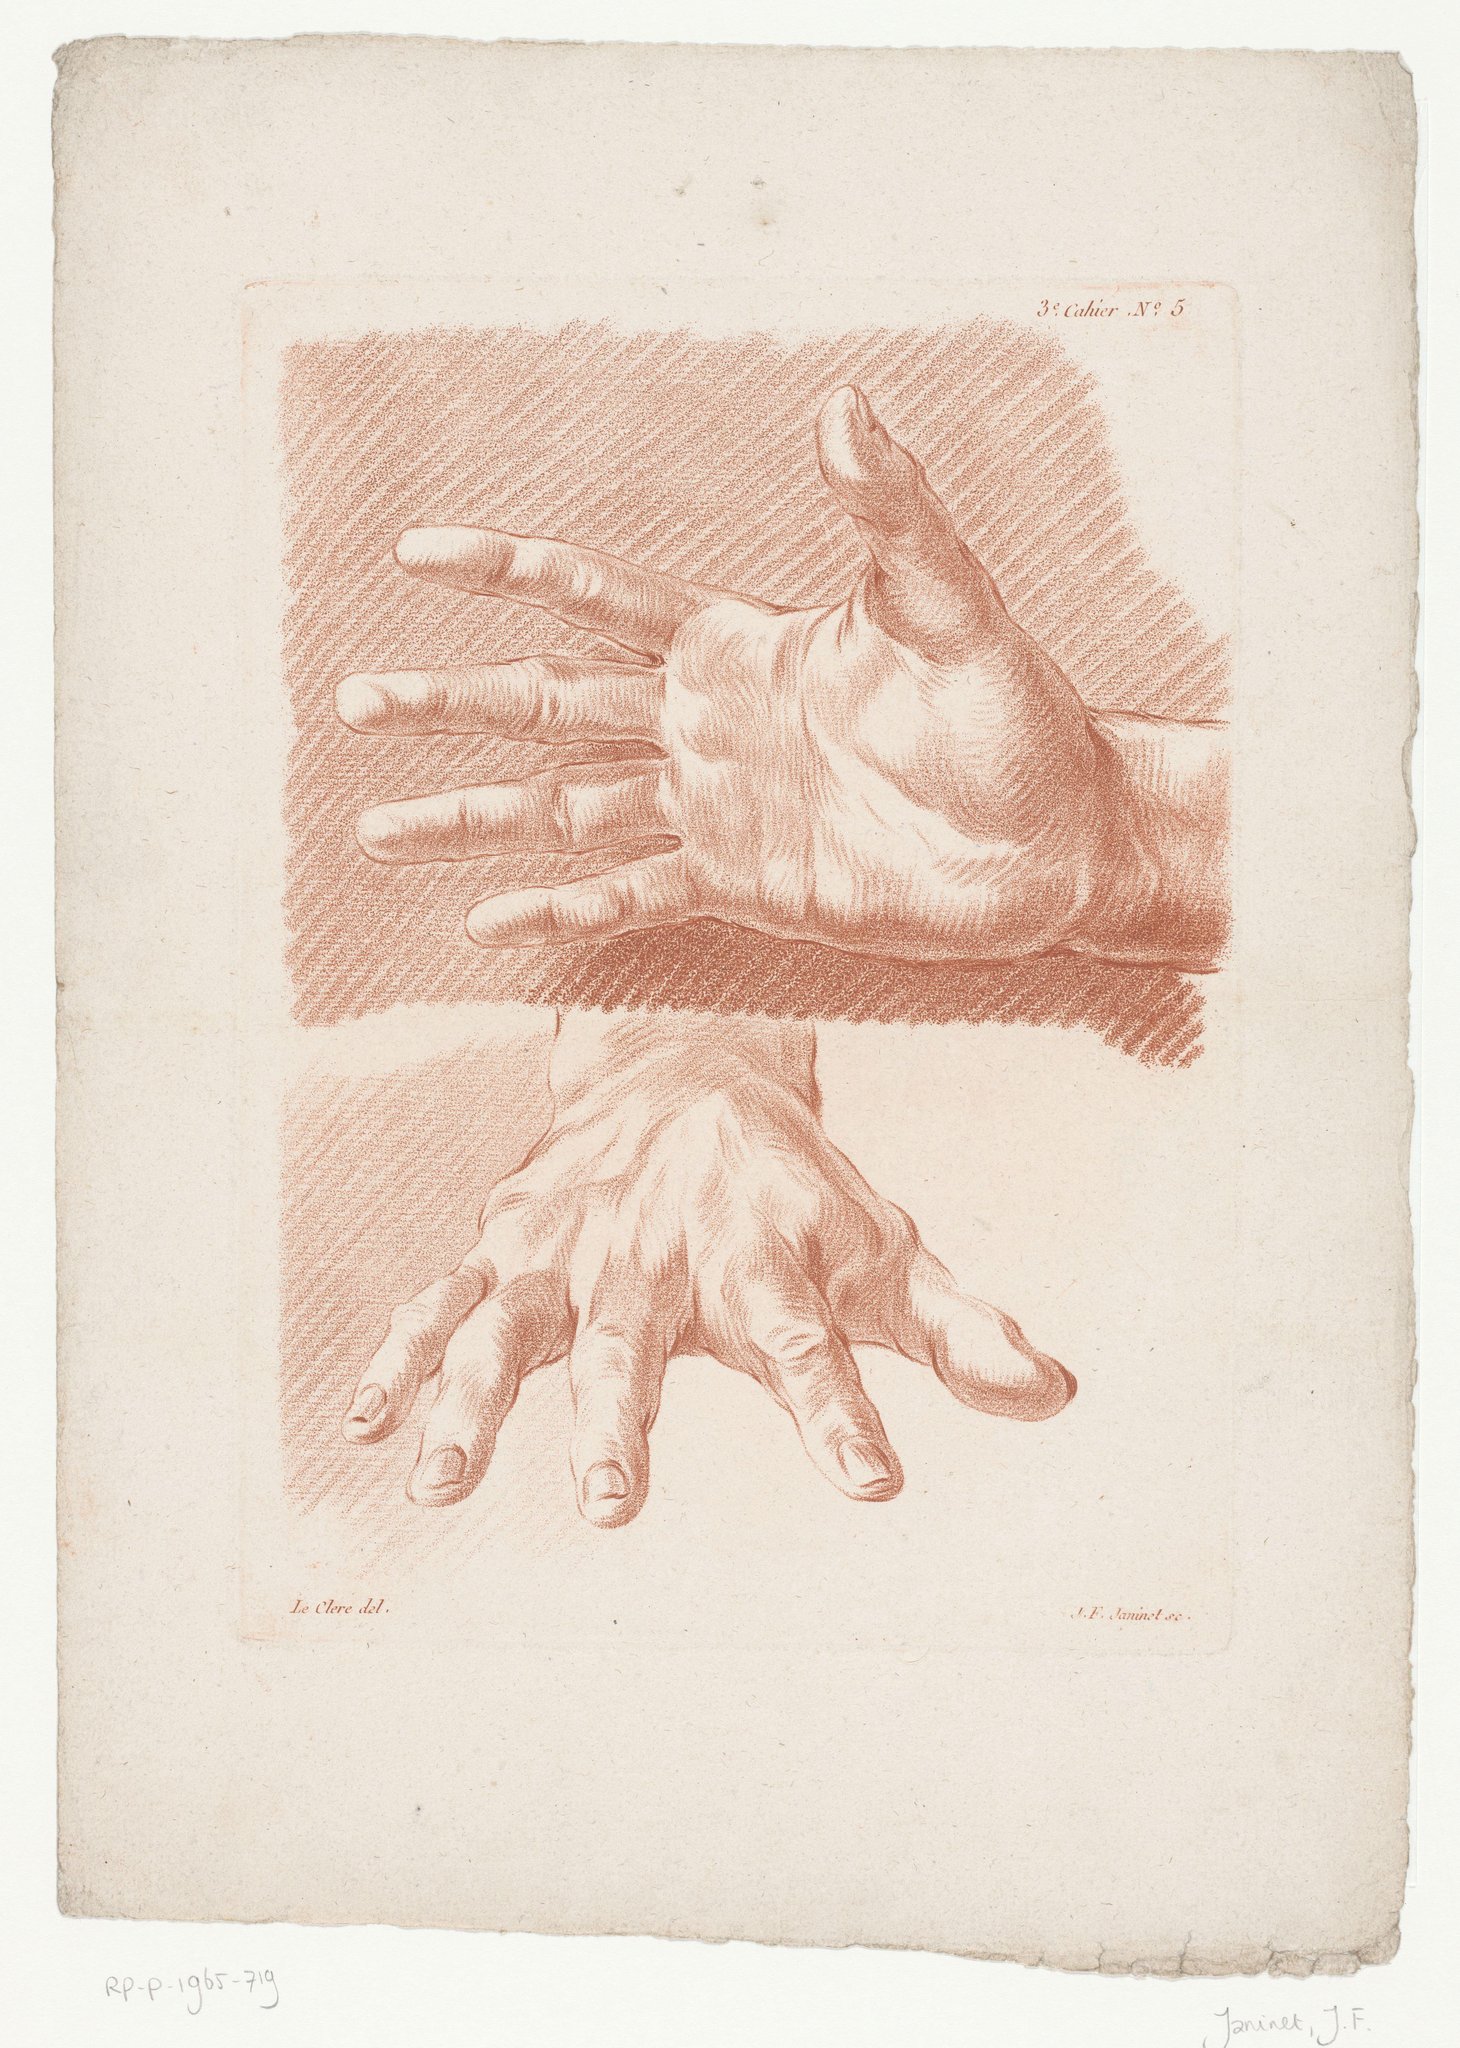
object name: print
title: IIIe Cahier de Principes de Dessins d'après nature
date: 1773-1777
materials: paper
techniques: printmaking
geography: paris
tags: hand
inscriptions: collector's mark: Lugt 2228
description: Deze prent maakt deel uit van een album dat uit minstens elf delen bestaat. Dit is het vijfde blad van het derde album. Waarschijnlijk dienden deze albums als voorbeeld voor tekenaars, schilders en graveurs.